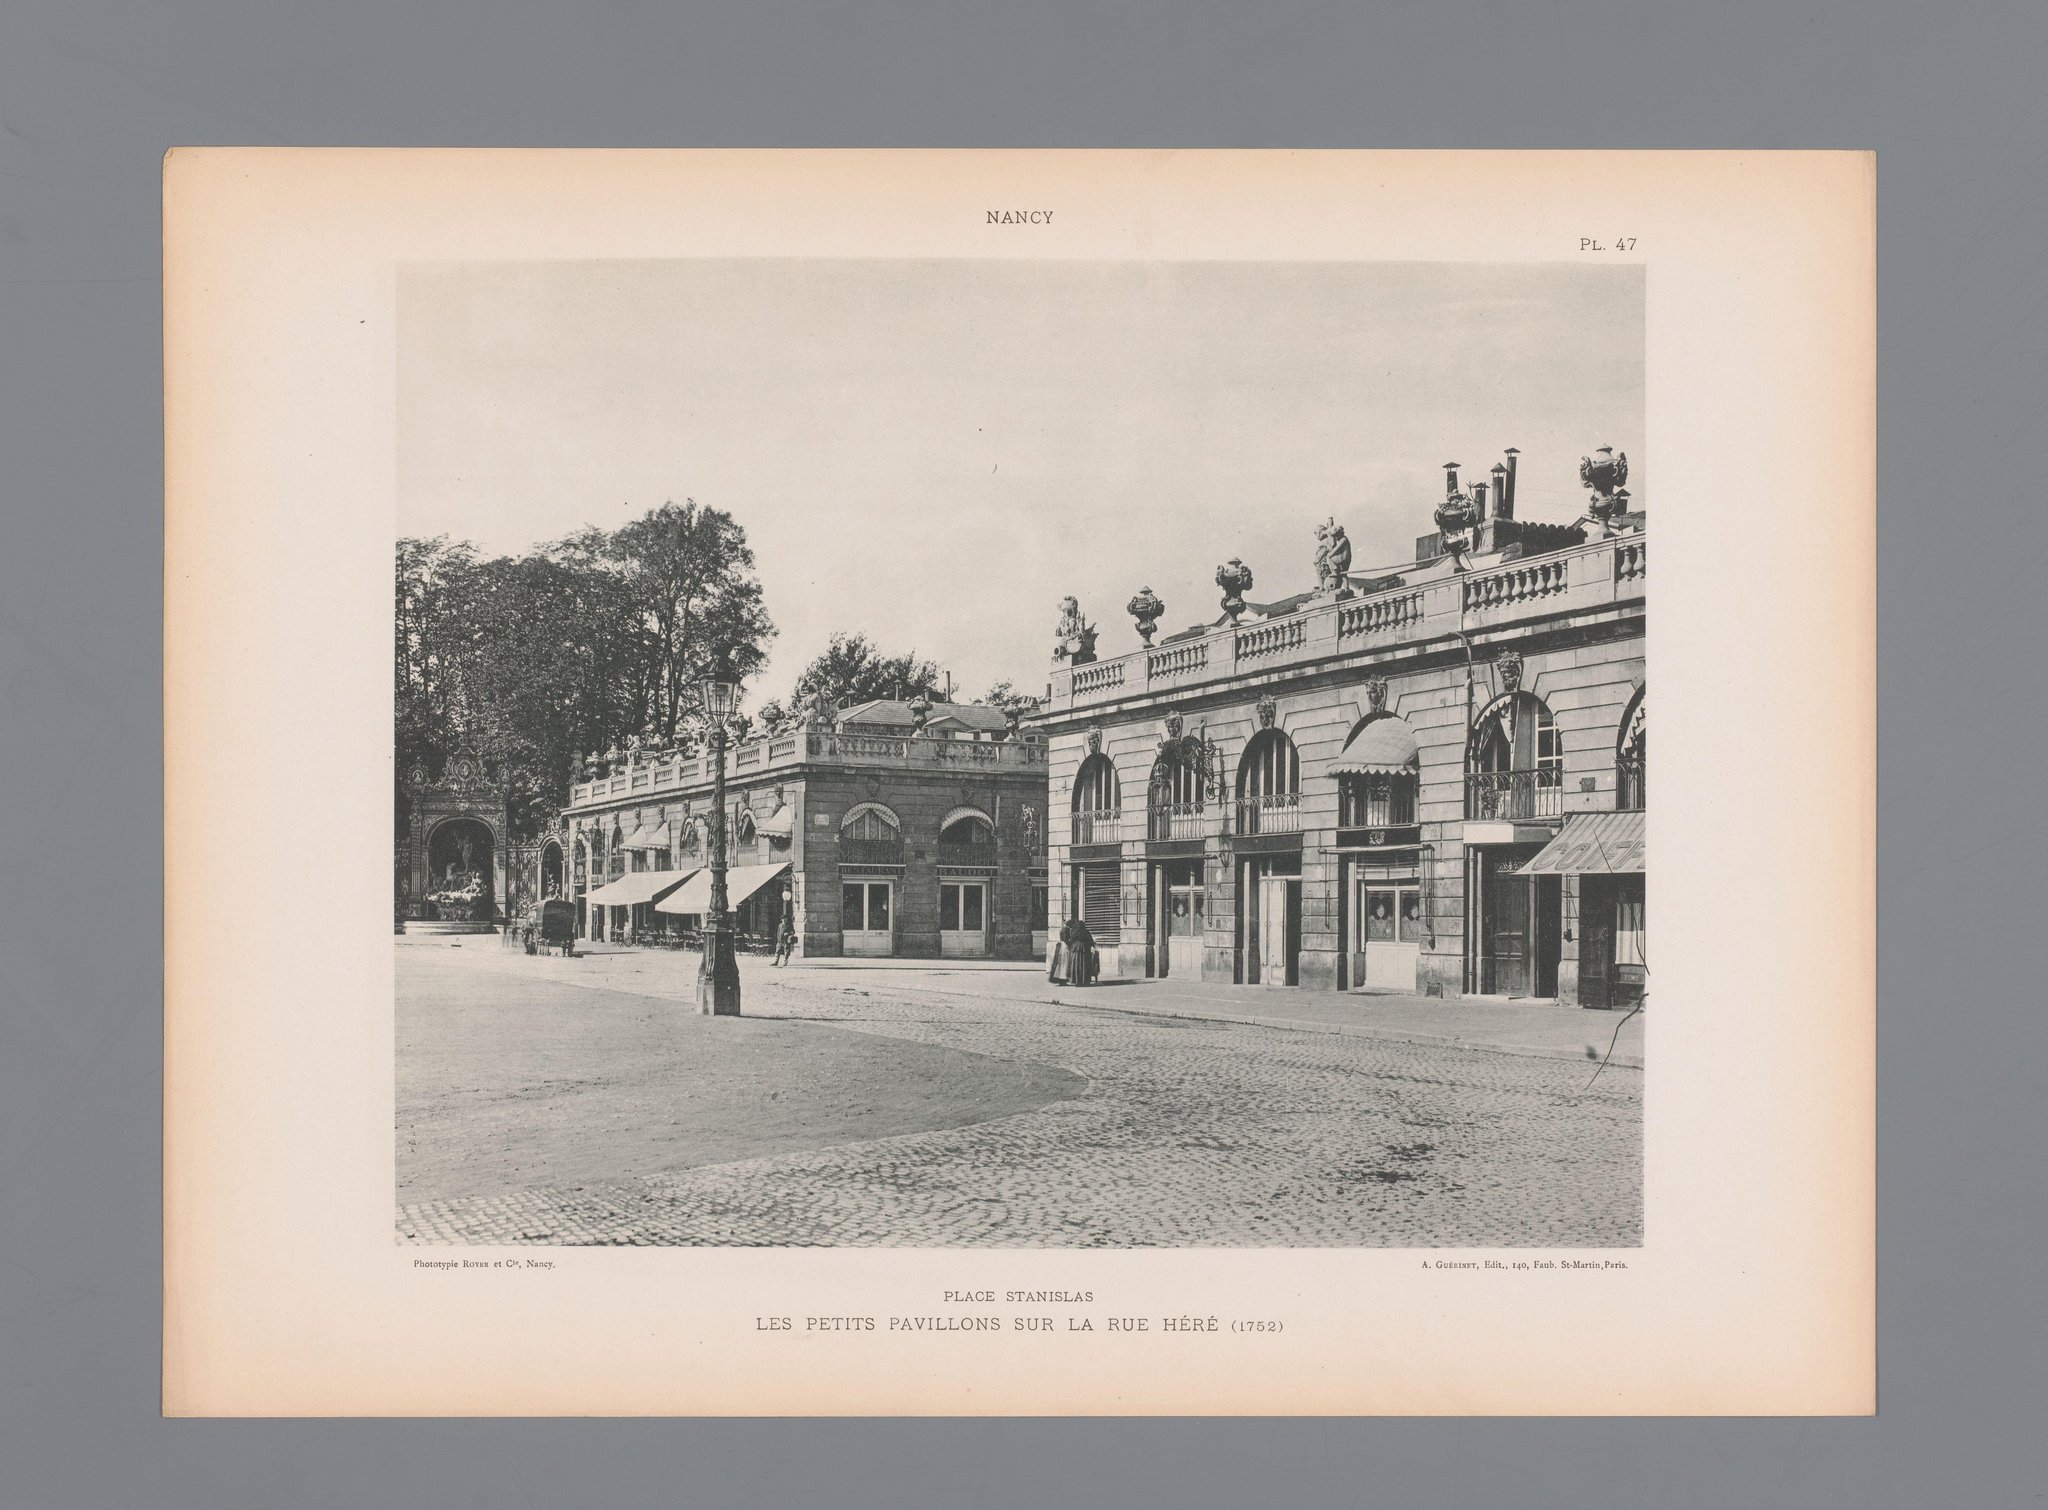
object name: photomechanical print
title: Paviljoens aan Place Stanislas te Nancy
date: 1891-1896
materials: paper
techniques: photograph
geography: nancy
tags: square, place, circus, etc., street (+ city(-scape) with figures, staffage)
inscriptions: inscription: ‘Place Stanislas/ Les petits pavillons sur la rue Héré (1752)’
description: Deze prent maakt deel uit van een omslag met 103 prenten op 101 bladen en een titelblad.